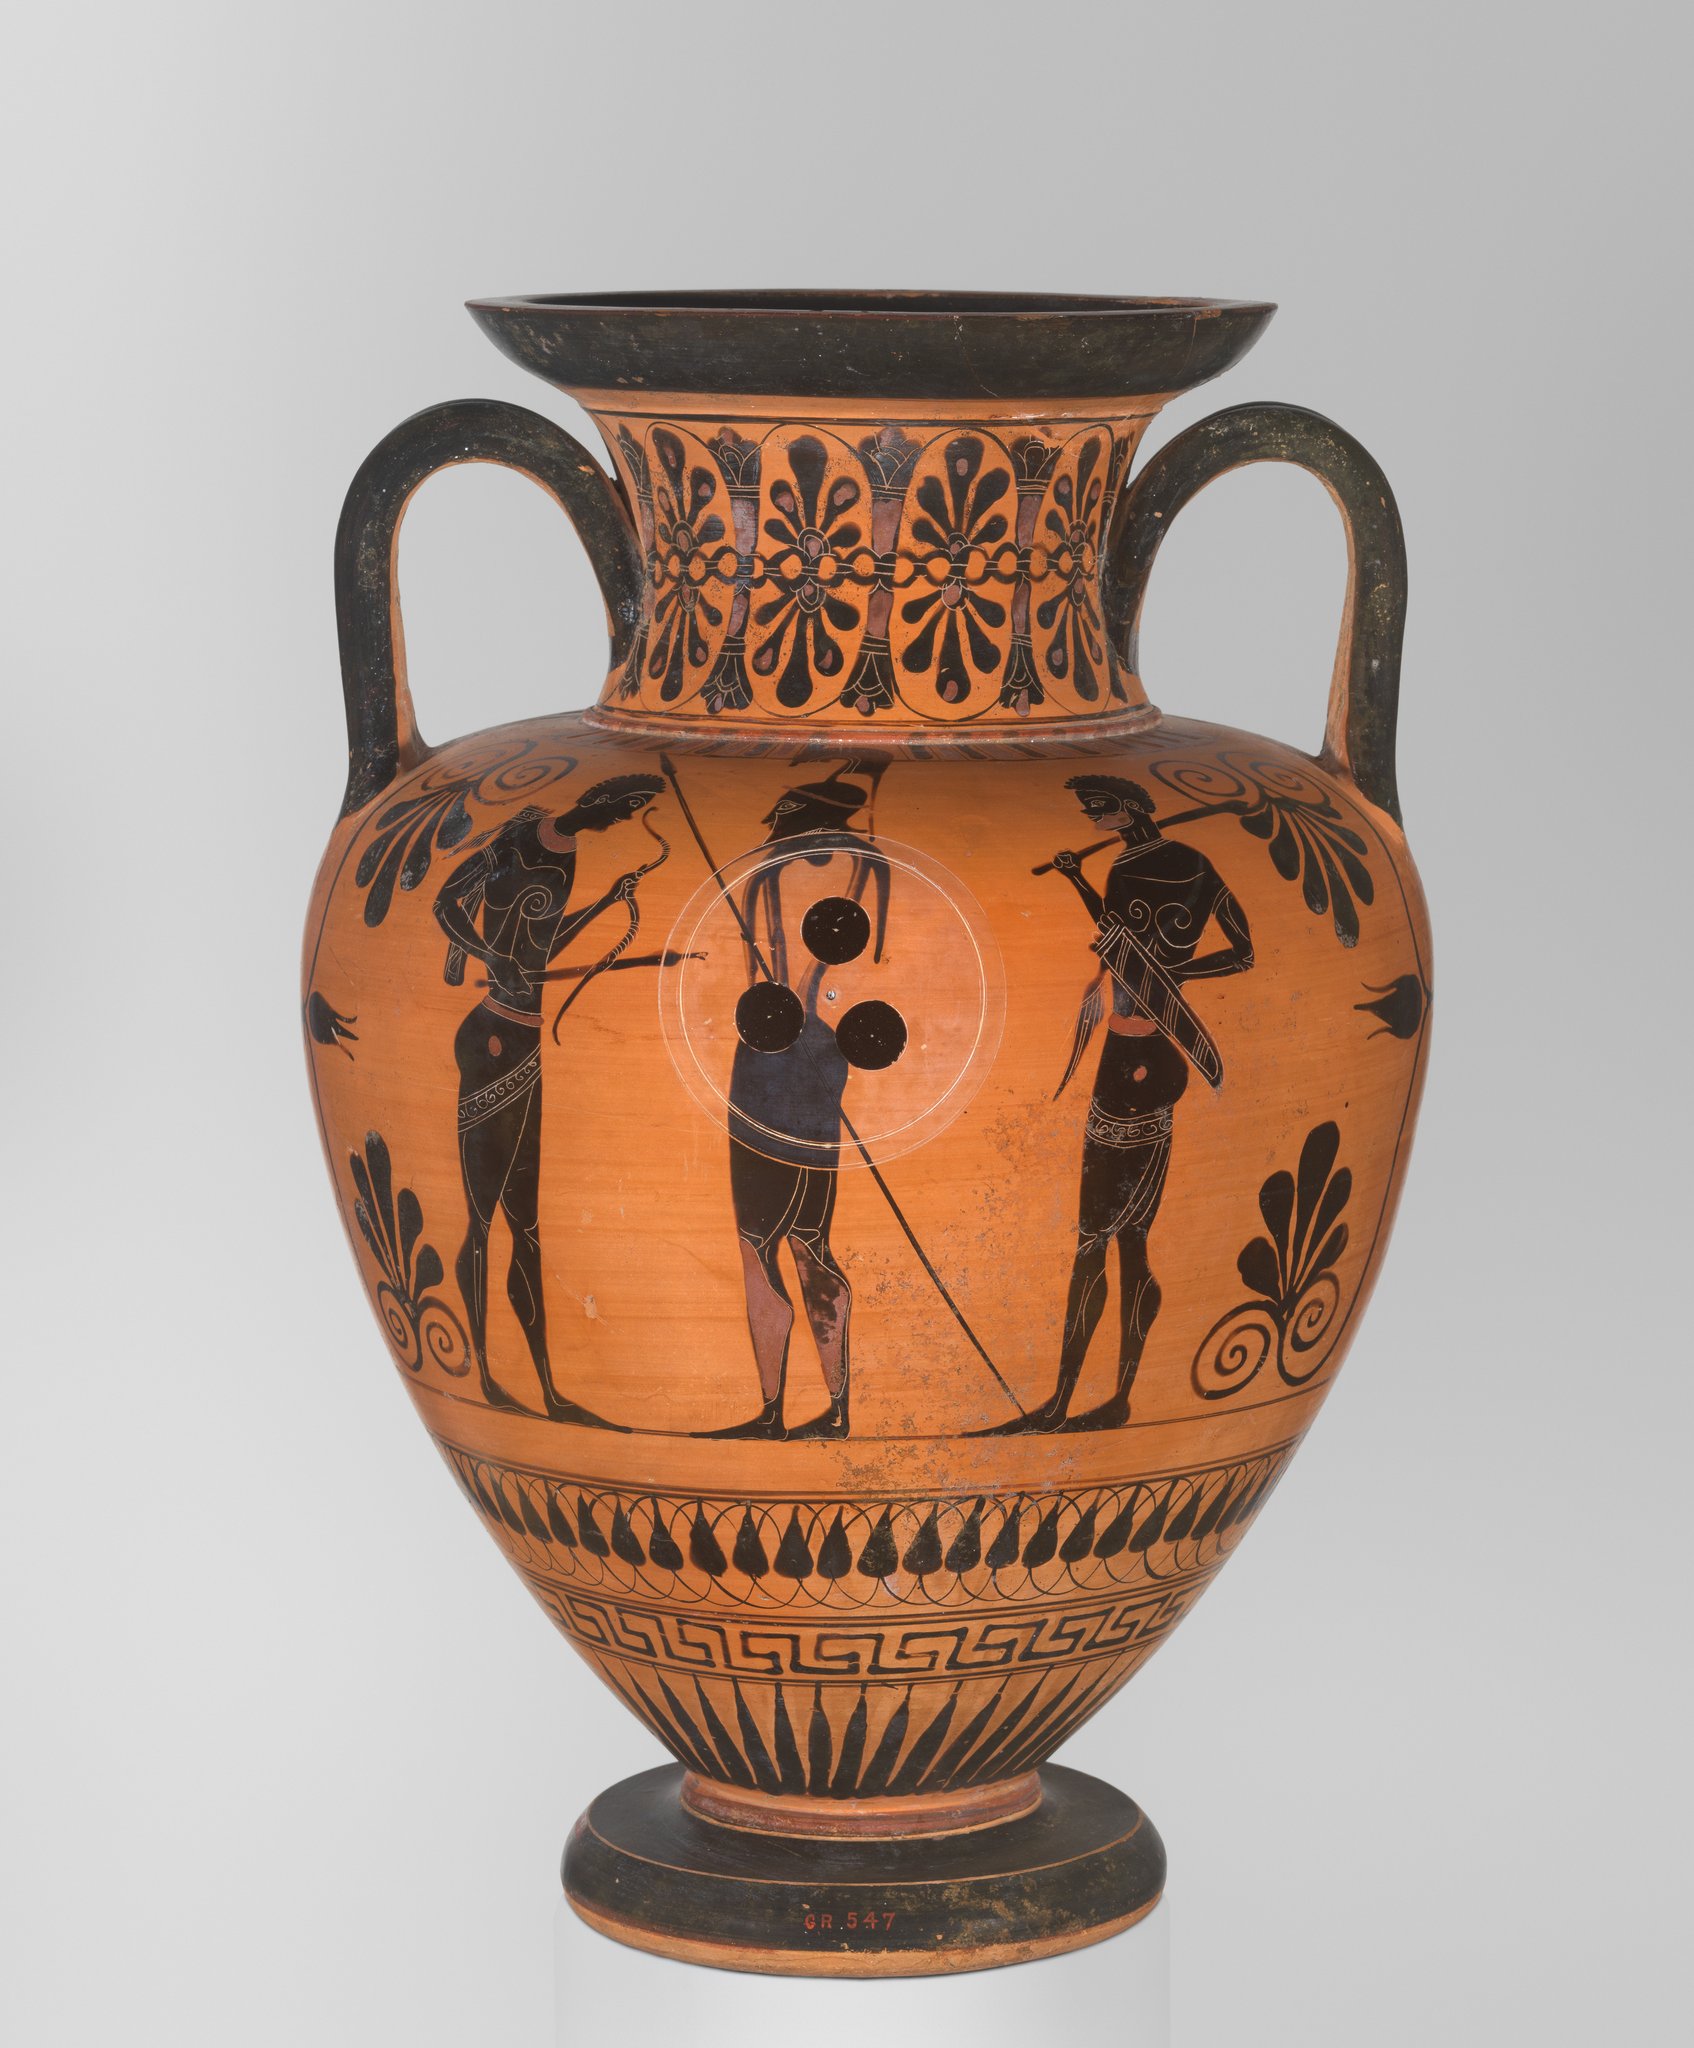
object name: neck amphora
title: Terracotta neck-amphora (jar)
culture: greek, attic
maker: exekias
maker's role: artist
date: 530 BCE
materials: terracotta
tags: trojan war,men,apollo,hermes